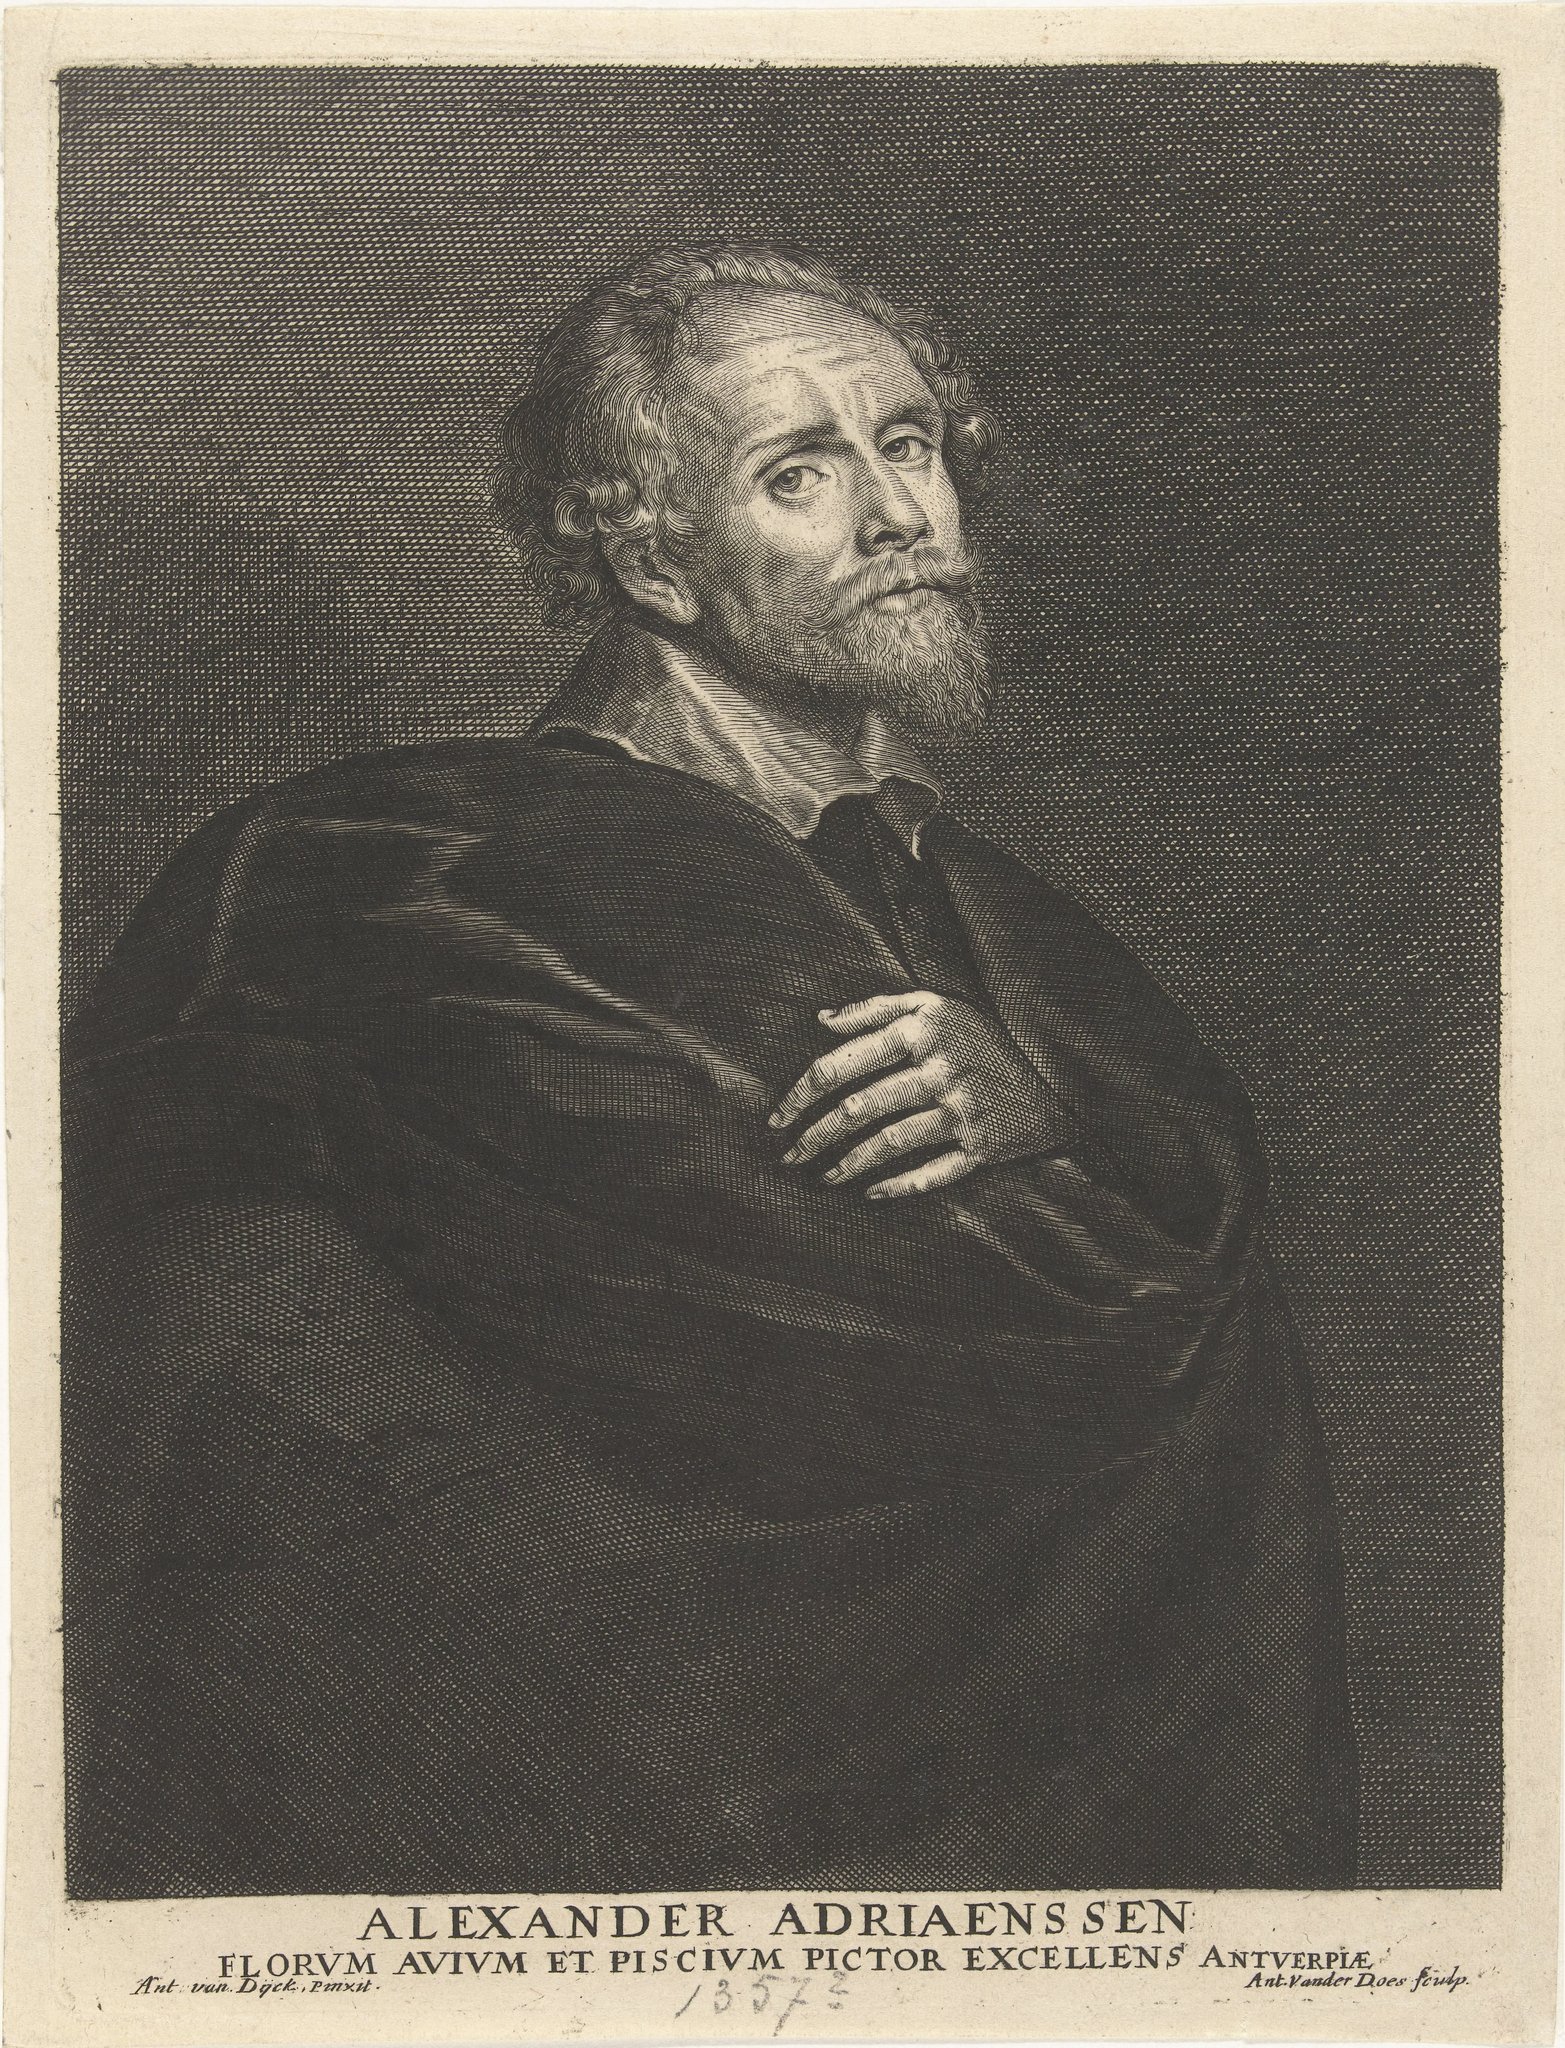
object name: print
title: Portret van Alexander Adriaensen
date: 1619-1680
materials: paper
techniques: engraving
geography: southern netherlands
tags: antwerp, painter, alexander adriaenssen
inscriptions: collector's mark: Lugt 2228, collector's mark: Lugt 2760